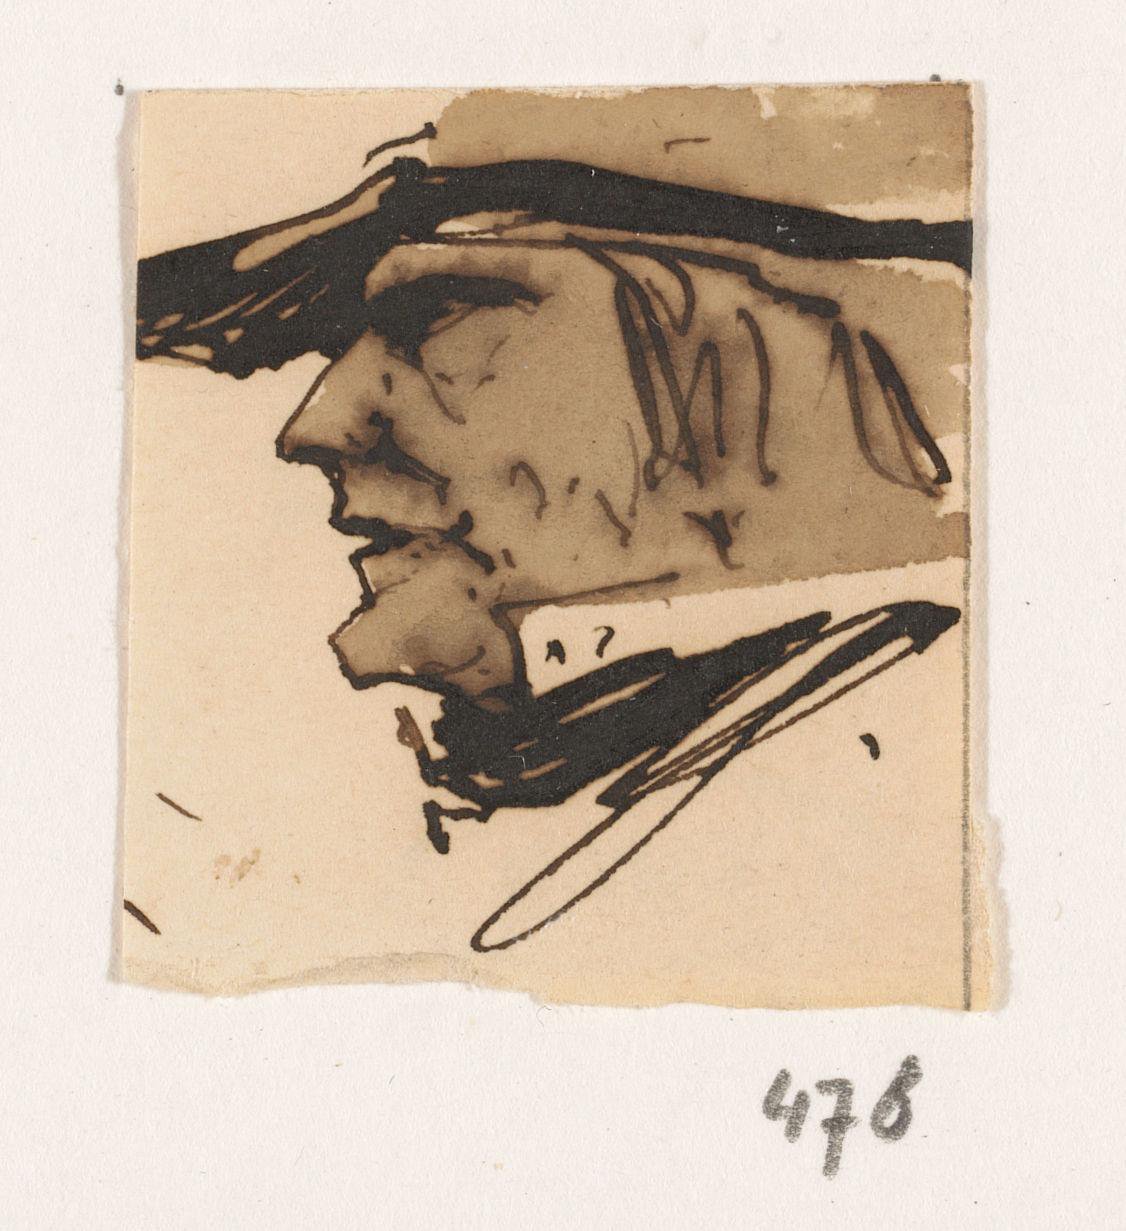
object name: drawing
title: Kop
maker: johannes tavenraat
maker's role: draughtsman, painter, print maker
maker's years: 1809-1881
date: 1840-1880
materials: ink, paper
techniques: brush, pen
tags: head (human), caricatures (human types)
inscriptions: collector's mark: Lugt 2228